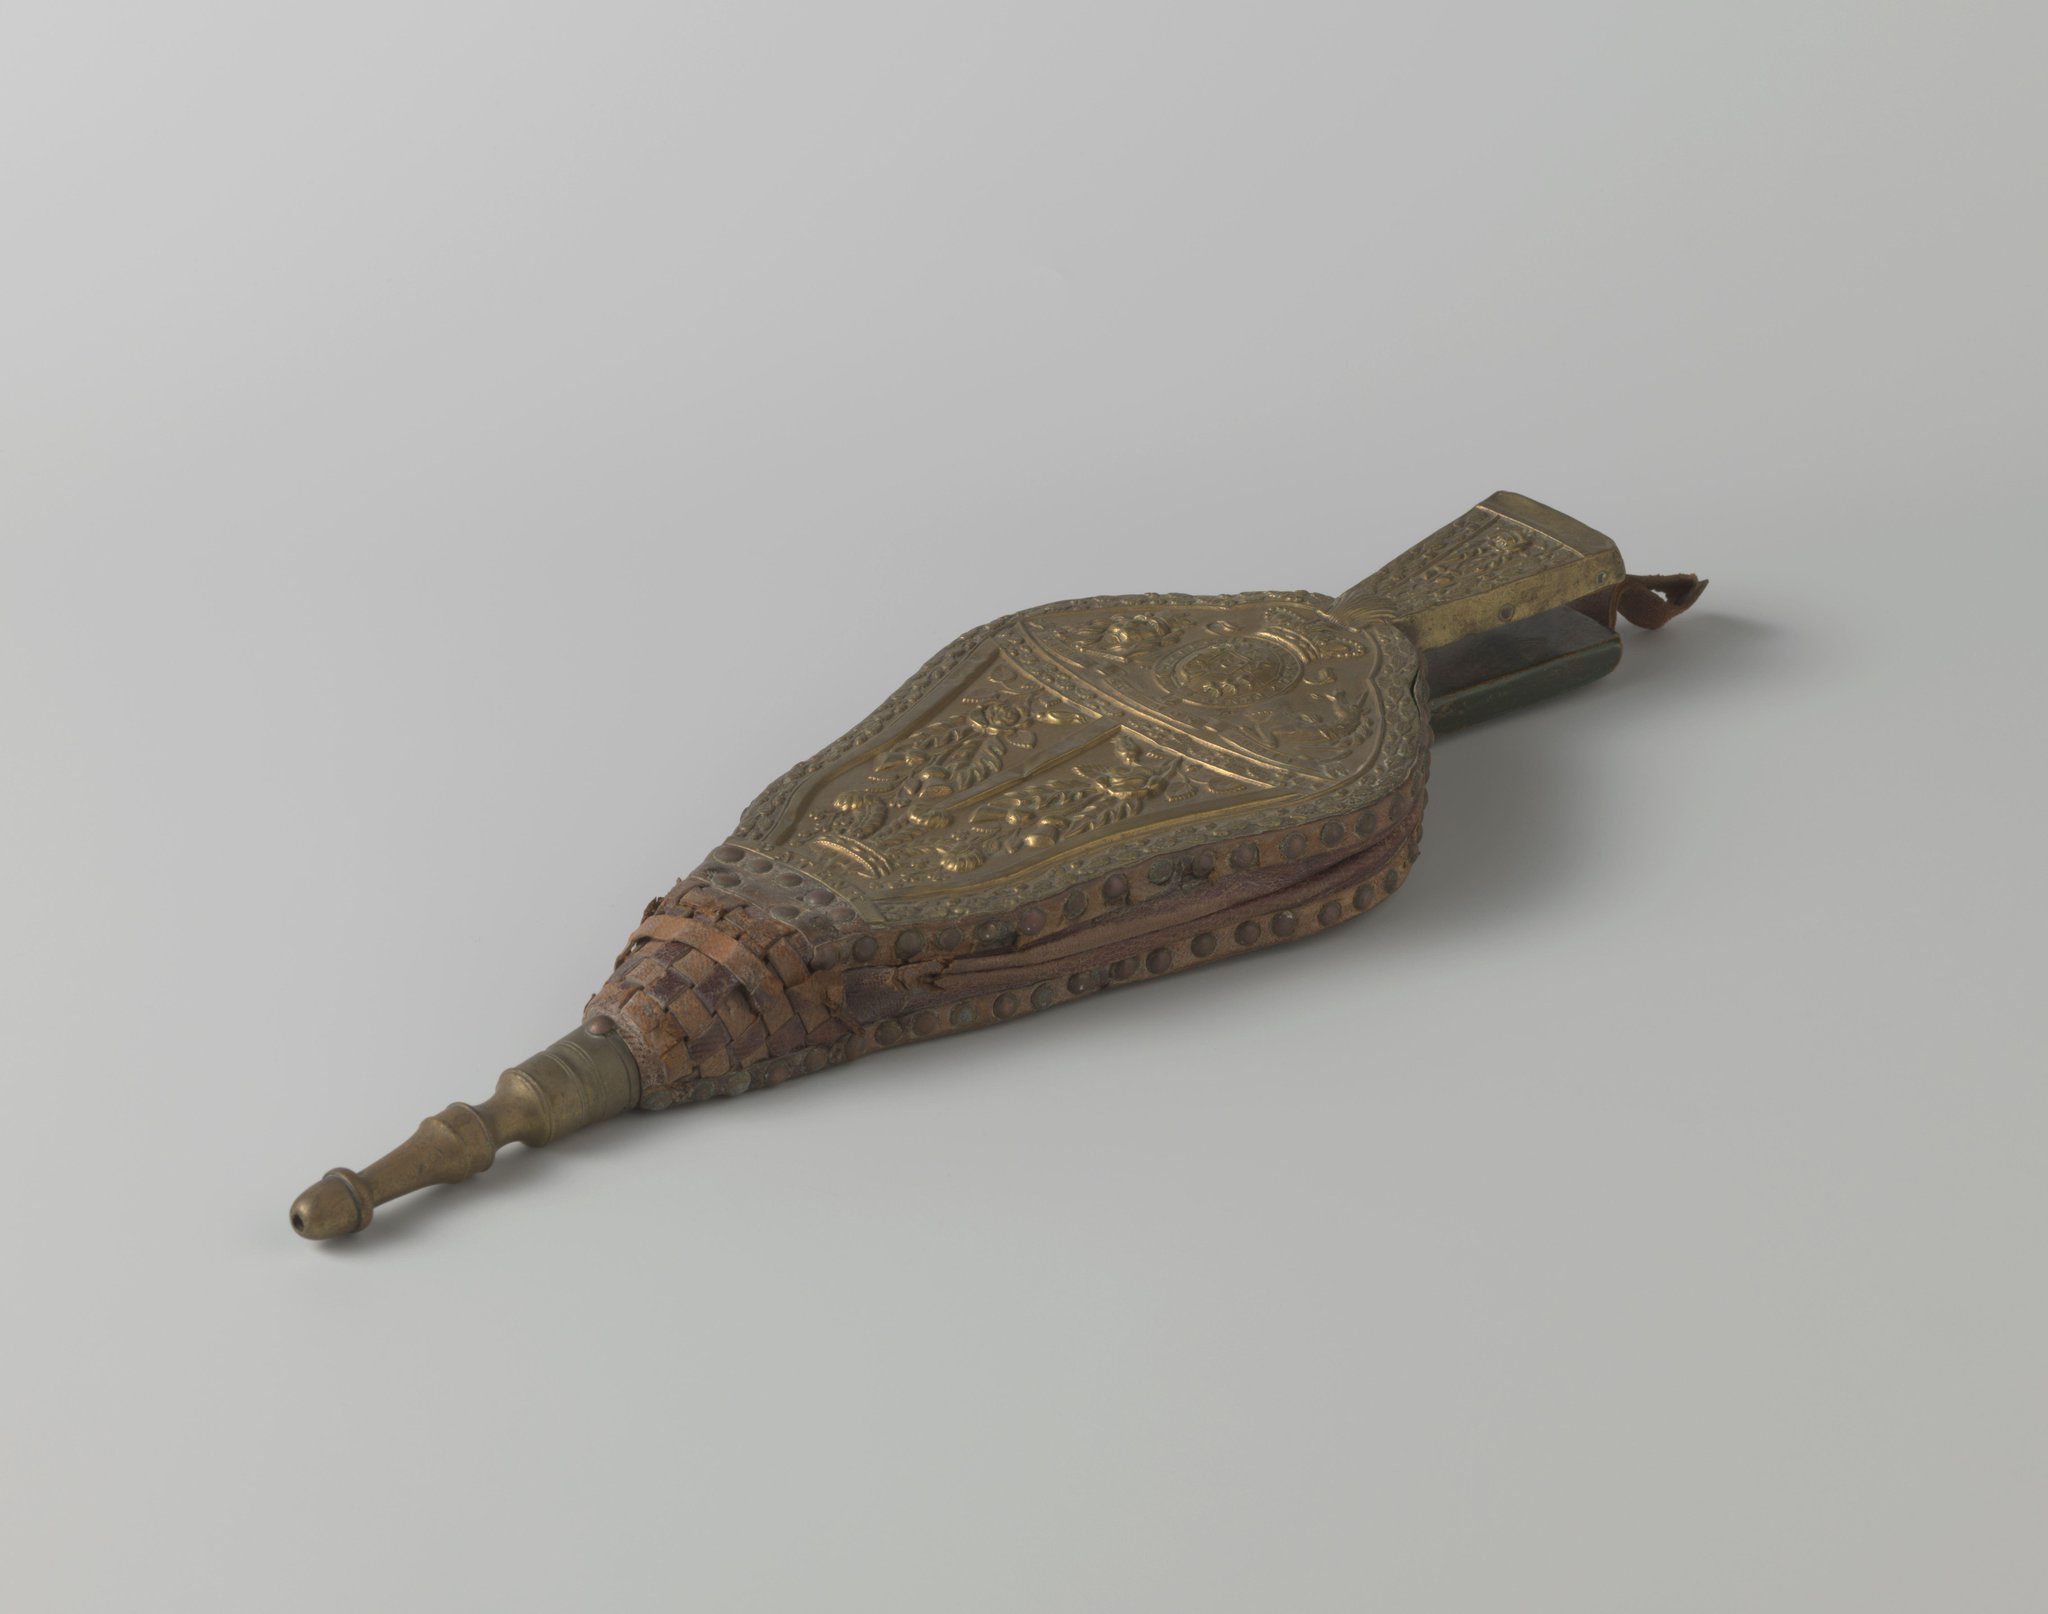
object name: bellow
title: Blaasbalg met wapen van George III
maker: Anonymous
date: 1800-1850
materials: brass, leather, paint, wood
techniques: pressing, riveted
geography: england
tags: george iii (koning van het verenigd koninkrijk)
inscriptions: inscription: ‘patent’, inscription: ‘Dieu et mon Droit’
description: Het voorwerp bestaat uit twe in handgrepen overgaande houten delen, die de onder- en bovenkant van de balg vormen, het daartussen aangebrachte rood geverfde leer, dat met nagels op de randen van die onderdelen is geklonken, en de buis van geel koper. De bovenkant is met geel koperplaat bekleed, waarin met behulp van een matrijs een versiering is geperst, bestaande uit het gekroonde en met het devies van de Orde van de Kouseband omgeven wapen van George III, koning van Groot-Brittannië, tussen een gekroonde leeuw en een eenhoorn en met het devies 'Dieu et mon Droit', voorts drie in een kroon geplaatste struisveren, slingers van rozen en distels en eikenloof langs de rand, alsmede de term 'patent'. De onderkant heeft in lak op groen achtergrond een beschildering met Chinese landschapsmotieven.